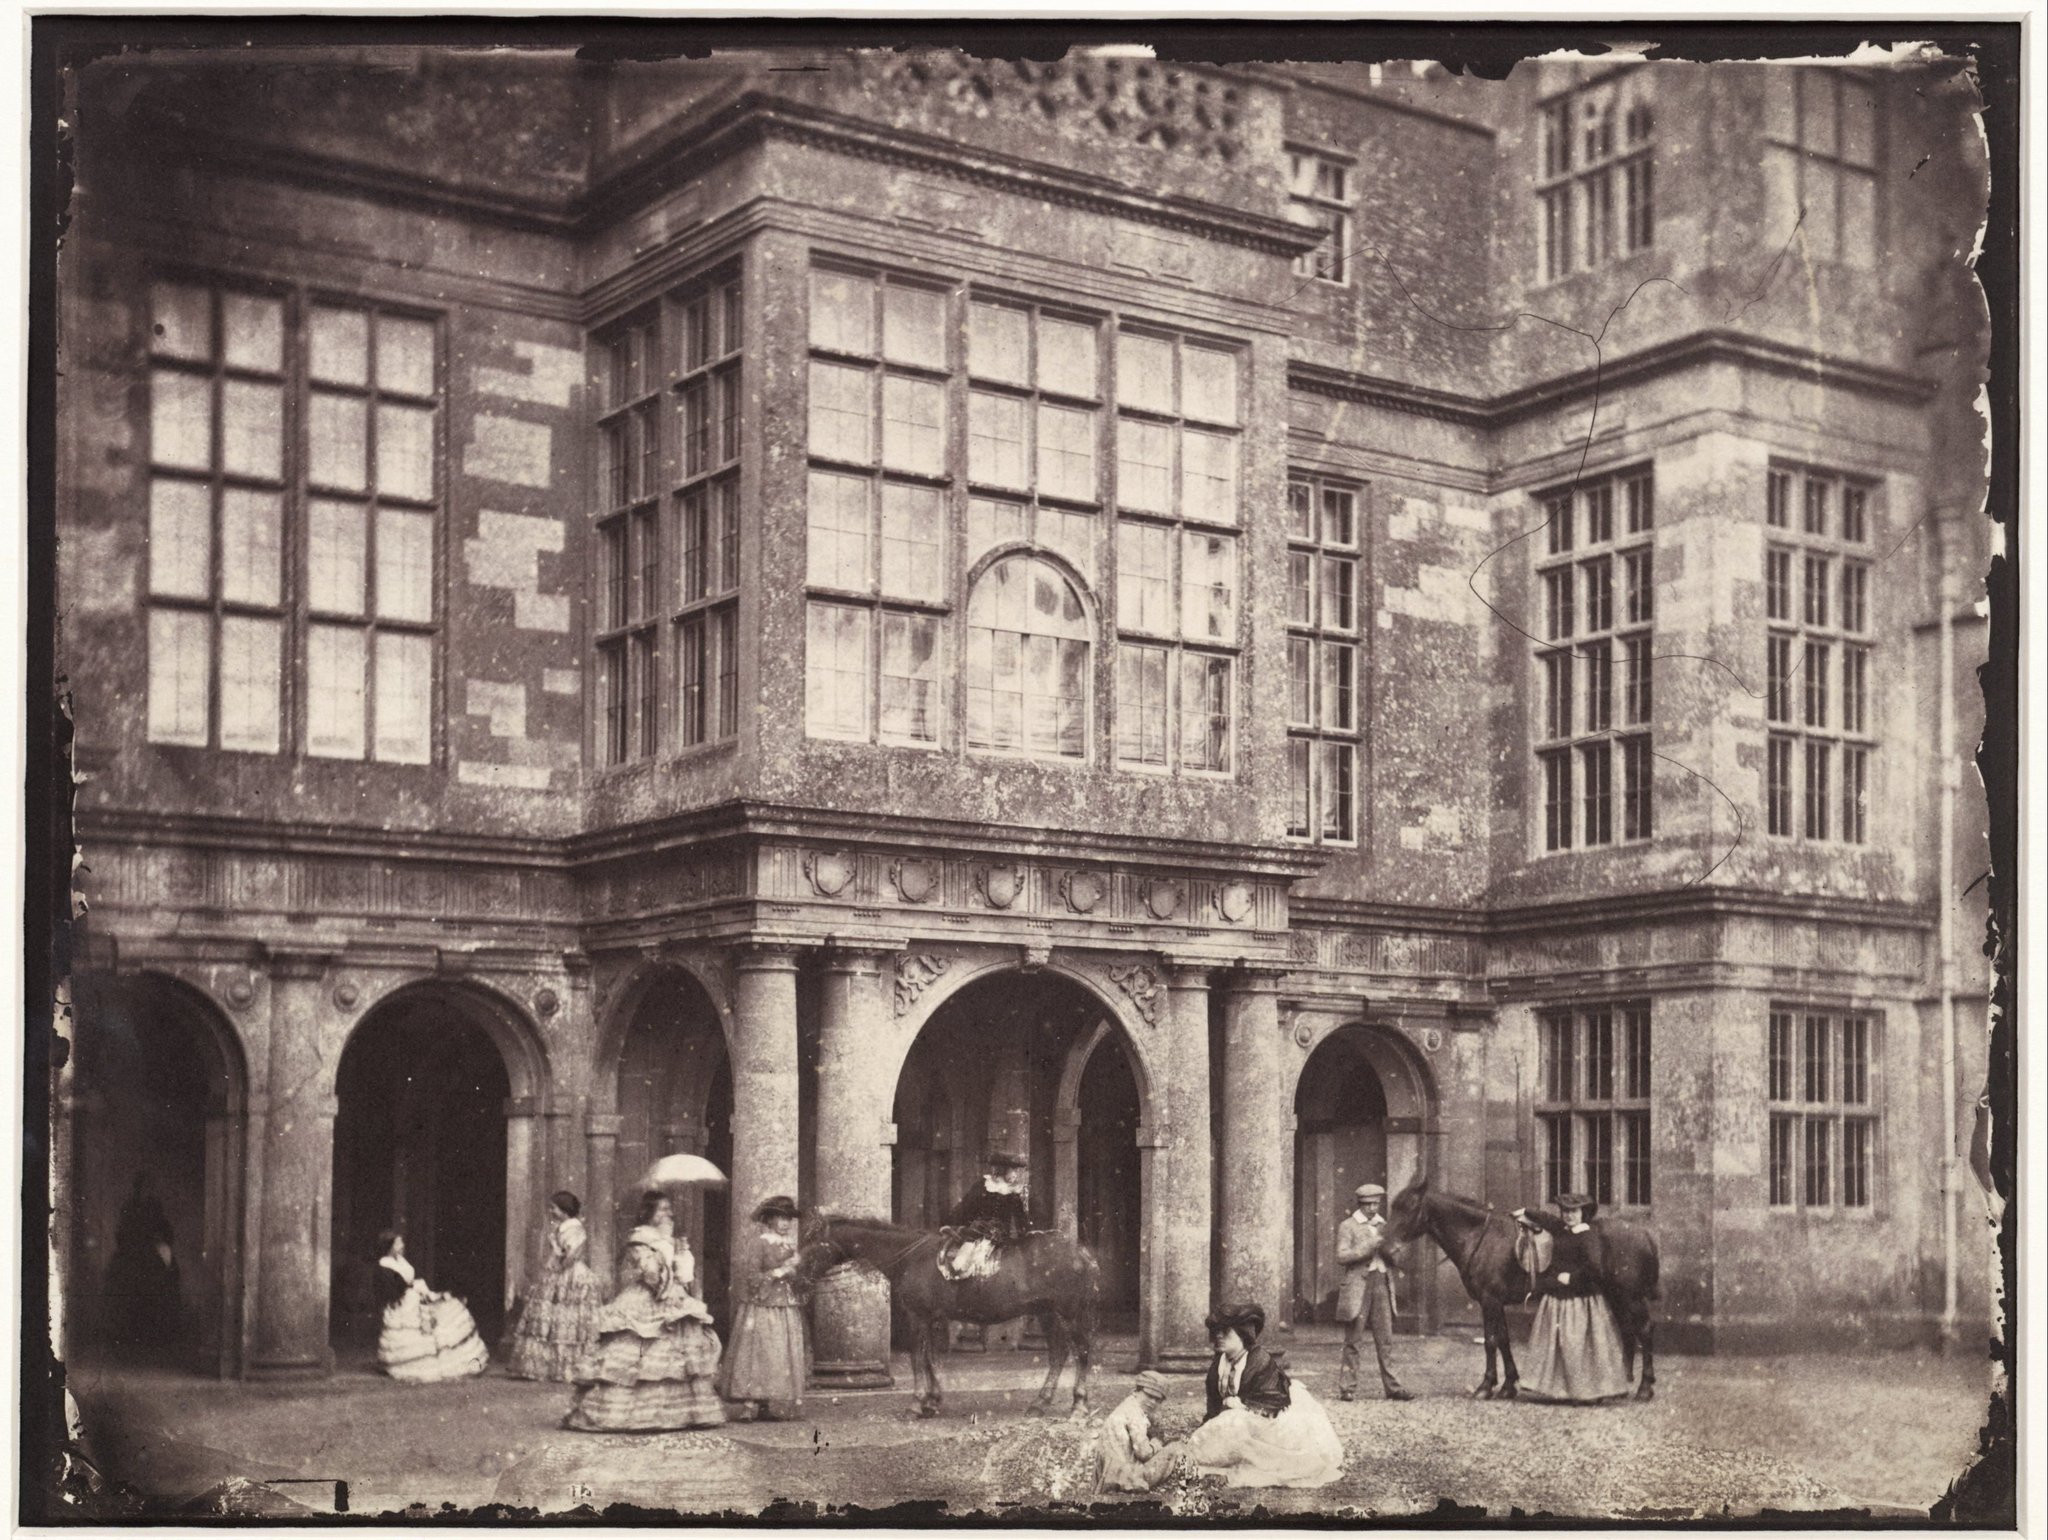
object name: photograph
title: Charlton Park House nabij Malmesbury in Wiltshire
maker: mervyn herbert nevil story-maskelyne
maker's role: fotograaf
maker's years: 1823-1911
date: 1856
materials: photographic support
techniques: salted paper print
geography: wiltshire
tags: palace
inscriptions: number: ‘352/2’, inscription: ‘Nevil/ Story/ Maskelyne/ Charlton/ House/ C11855’